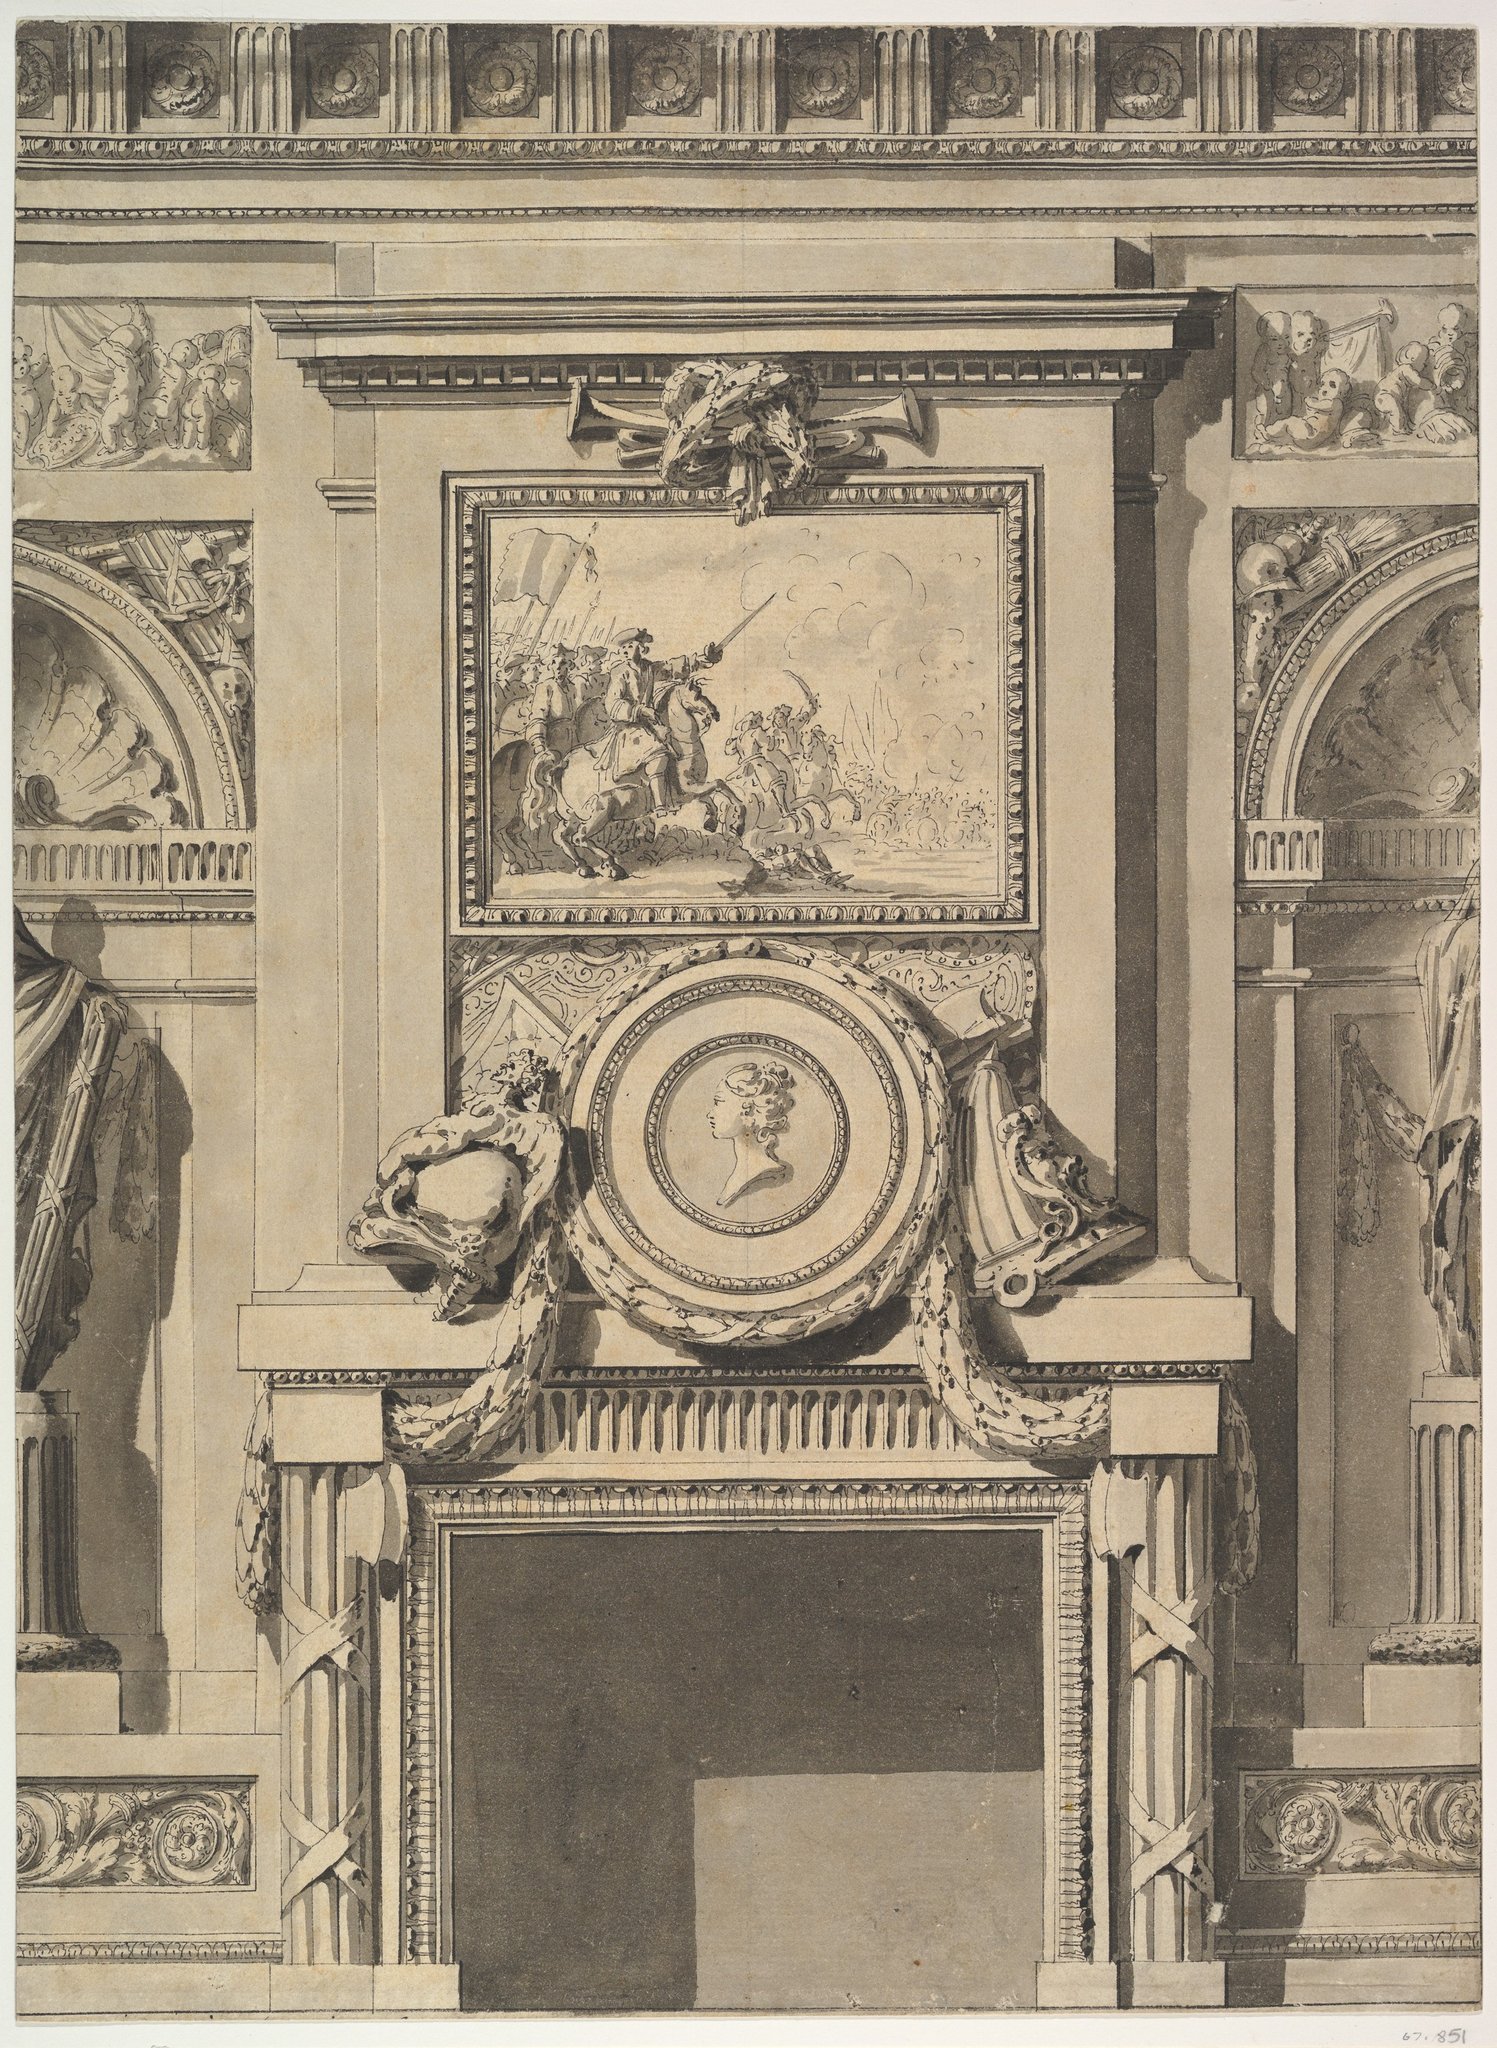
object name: drawing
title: Design for a Chimneypiece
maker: jean charles delafosse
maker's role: artist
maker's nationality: french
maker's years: 1734-1789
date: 1734-1789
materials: ink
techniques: brush, pen, wash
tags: fireplaces,profiles,women